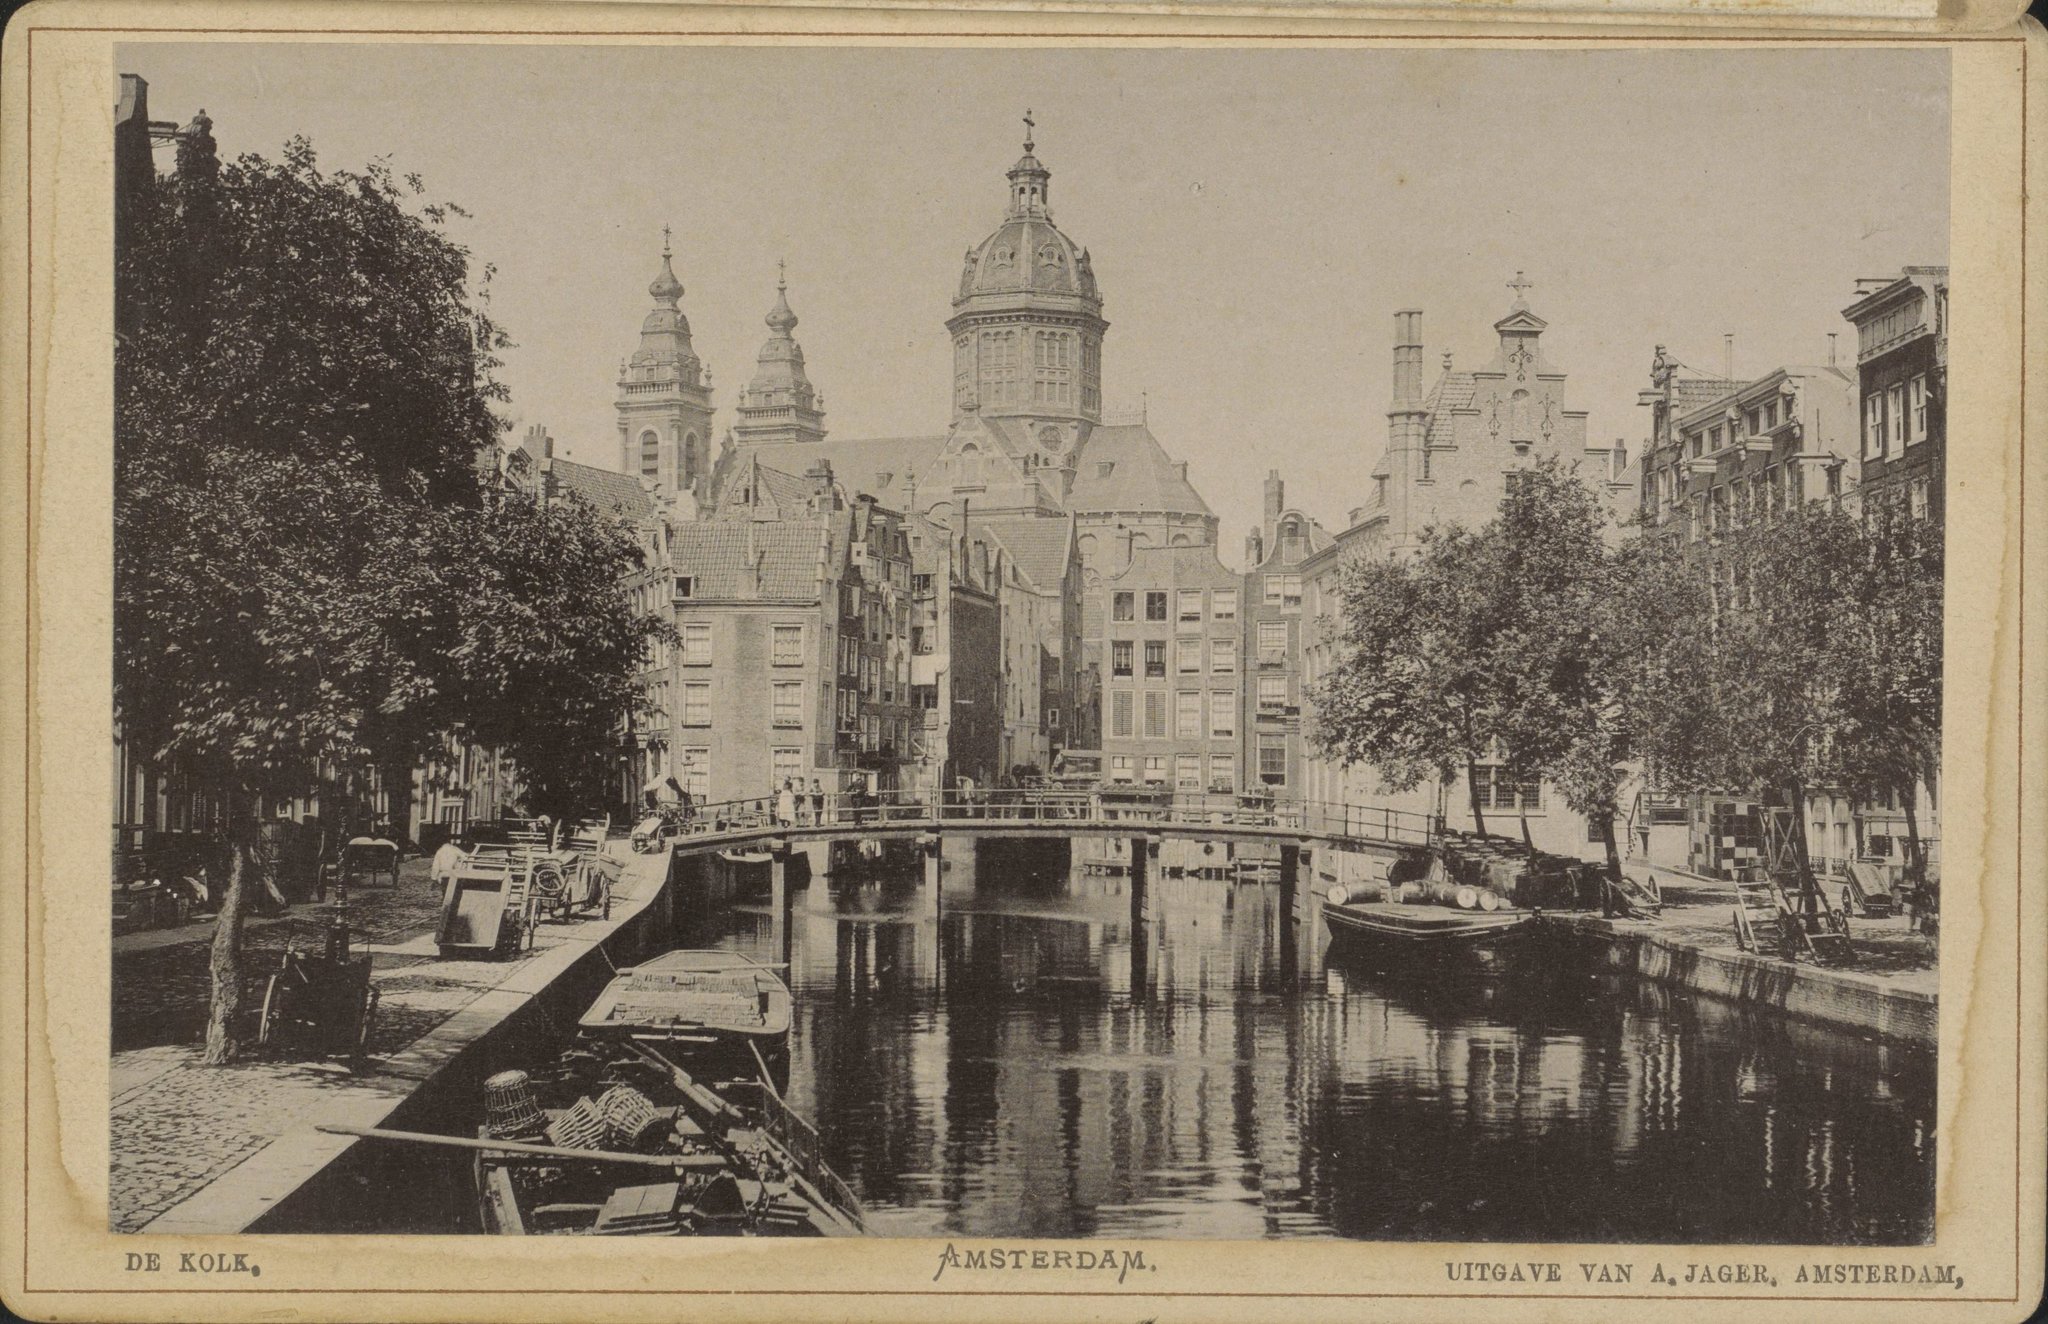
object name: photograph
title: Oudezijds Voorburgwal gezien naar de Oudezijds Kolk en de St. Nicolaaskerk in Amsterdam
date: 1880-1895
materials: cardboard, paper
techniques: photograph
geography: amsterdam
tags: basiliek van de heilige nicolaas, oudezijds voorburgwal, oudezijds kolk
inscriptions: inscription: ‘DE KOLK. AMSTERDAM. UITGAVE VAN A. JAGER, AMSTERDAM,’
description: Oudezijds Voorburgwal gezien naar de Oudezijds Kolk en de St. Nicolaaskerk in Amsterdam